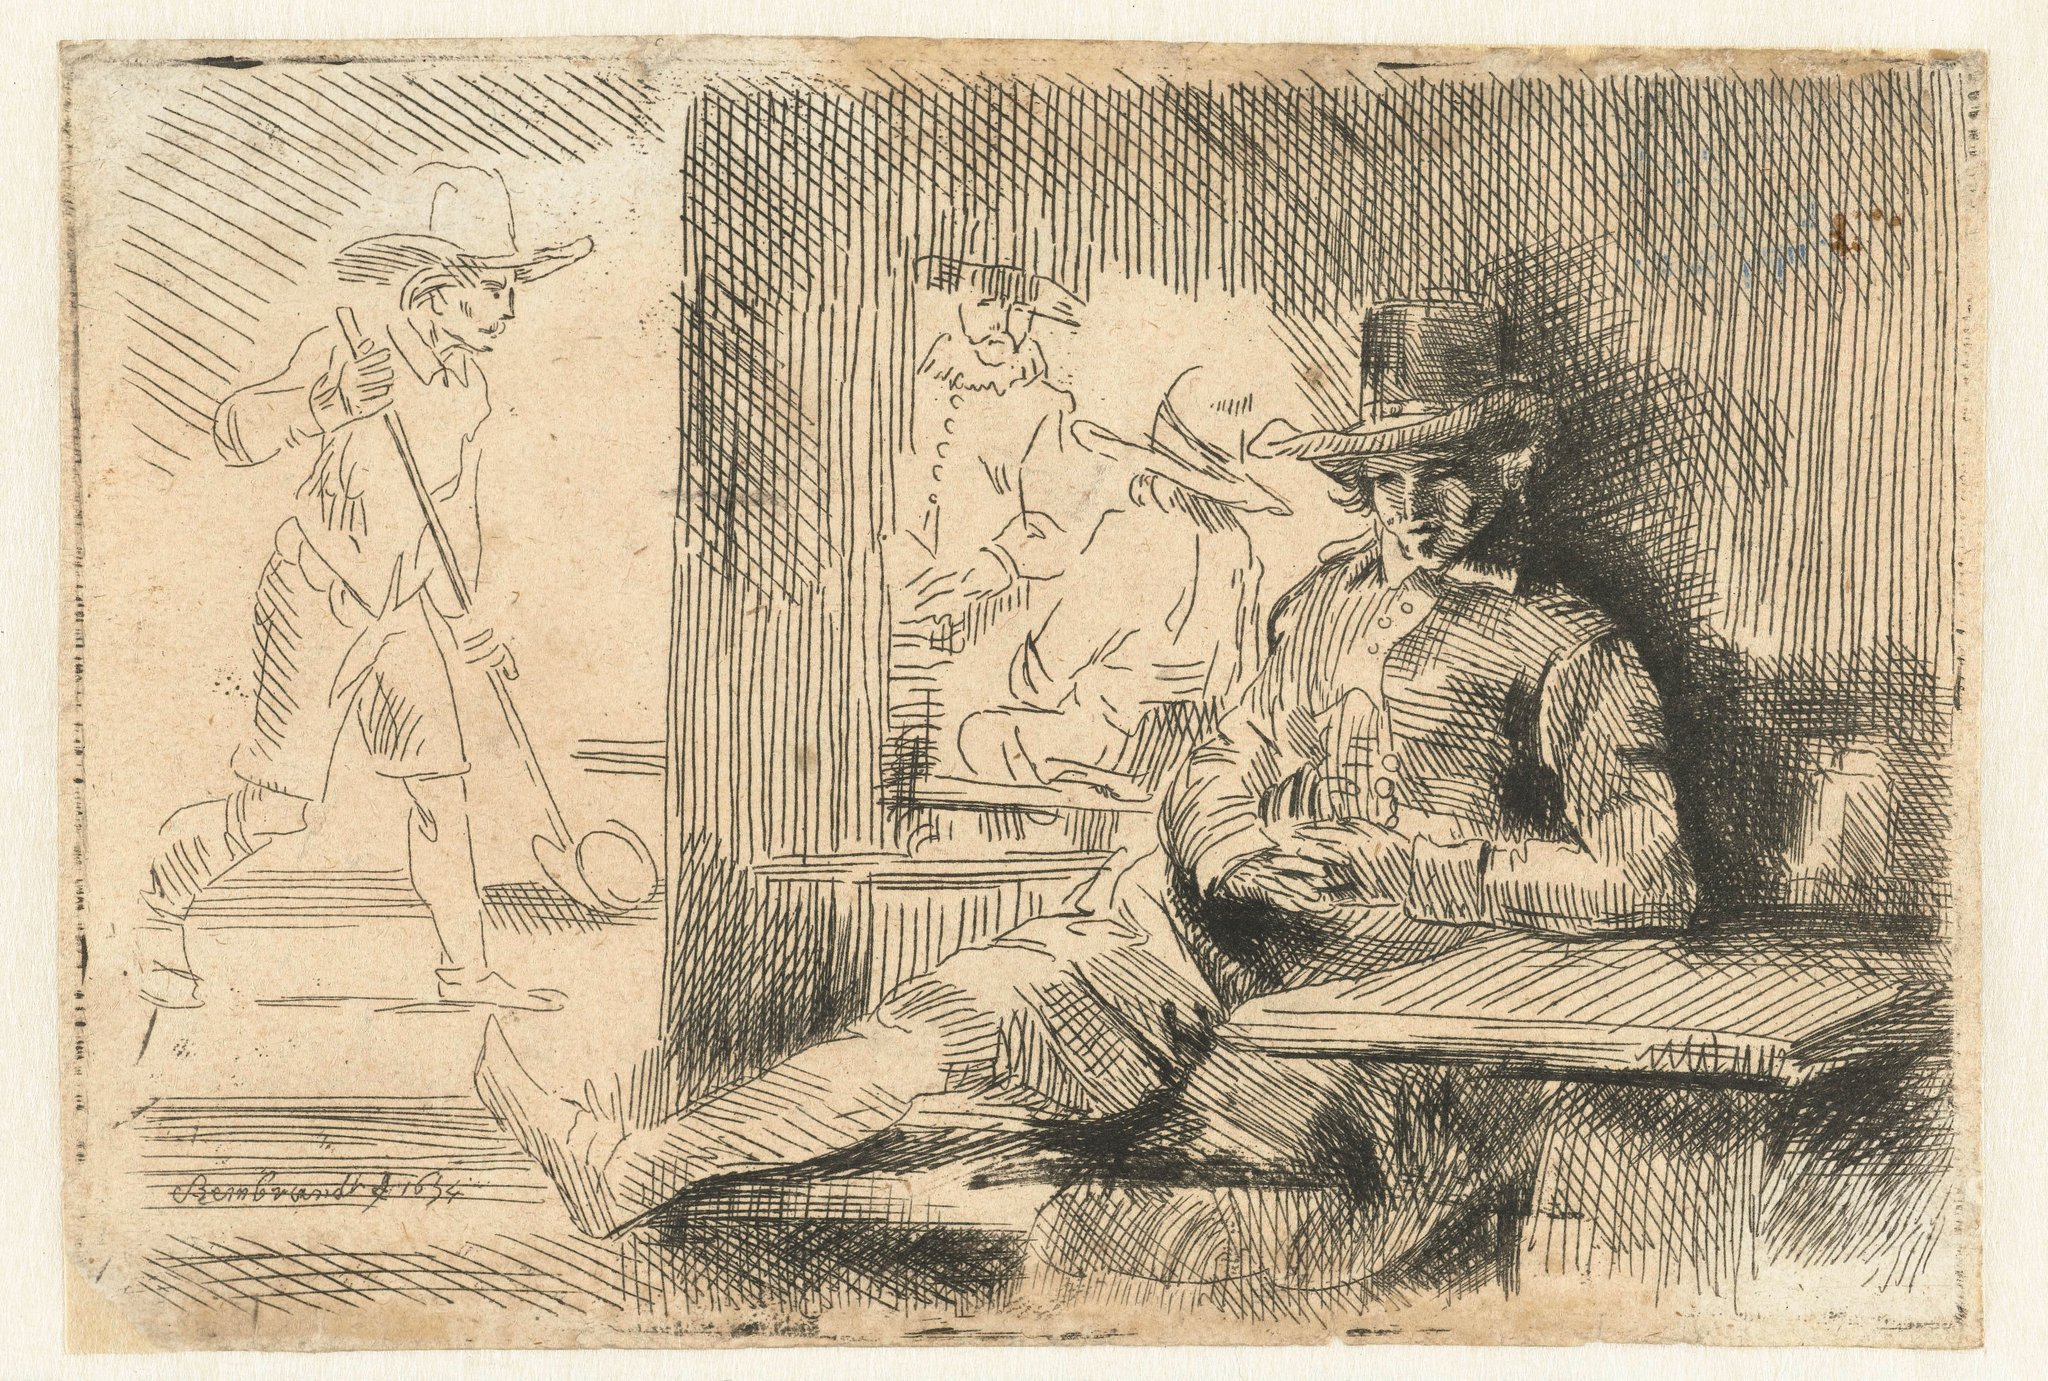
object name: print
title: The ringball player ('Het klosbaantje')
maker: Anonymous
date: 1654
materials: paper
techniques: etching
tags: golf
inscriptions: stamp, collector's mark: Lugt 2228, collector's mark: Lugt 2760